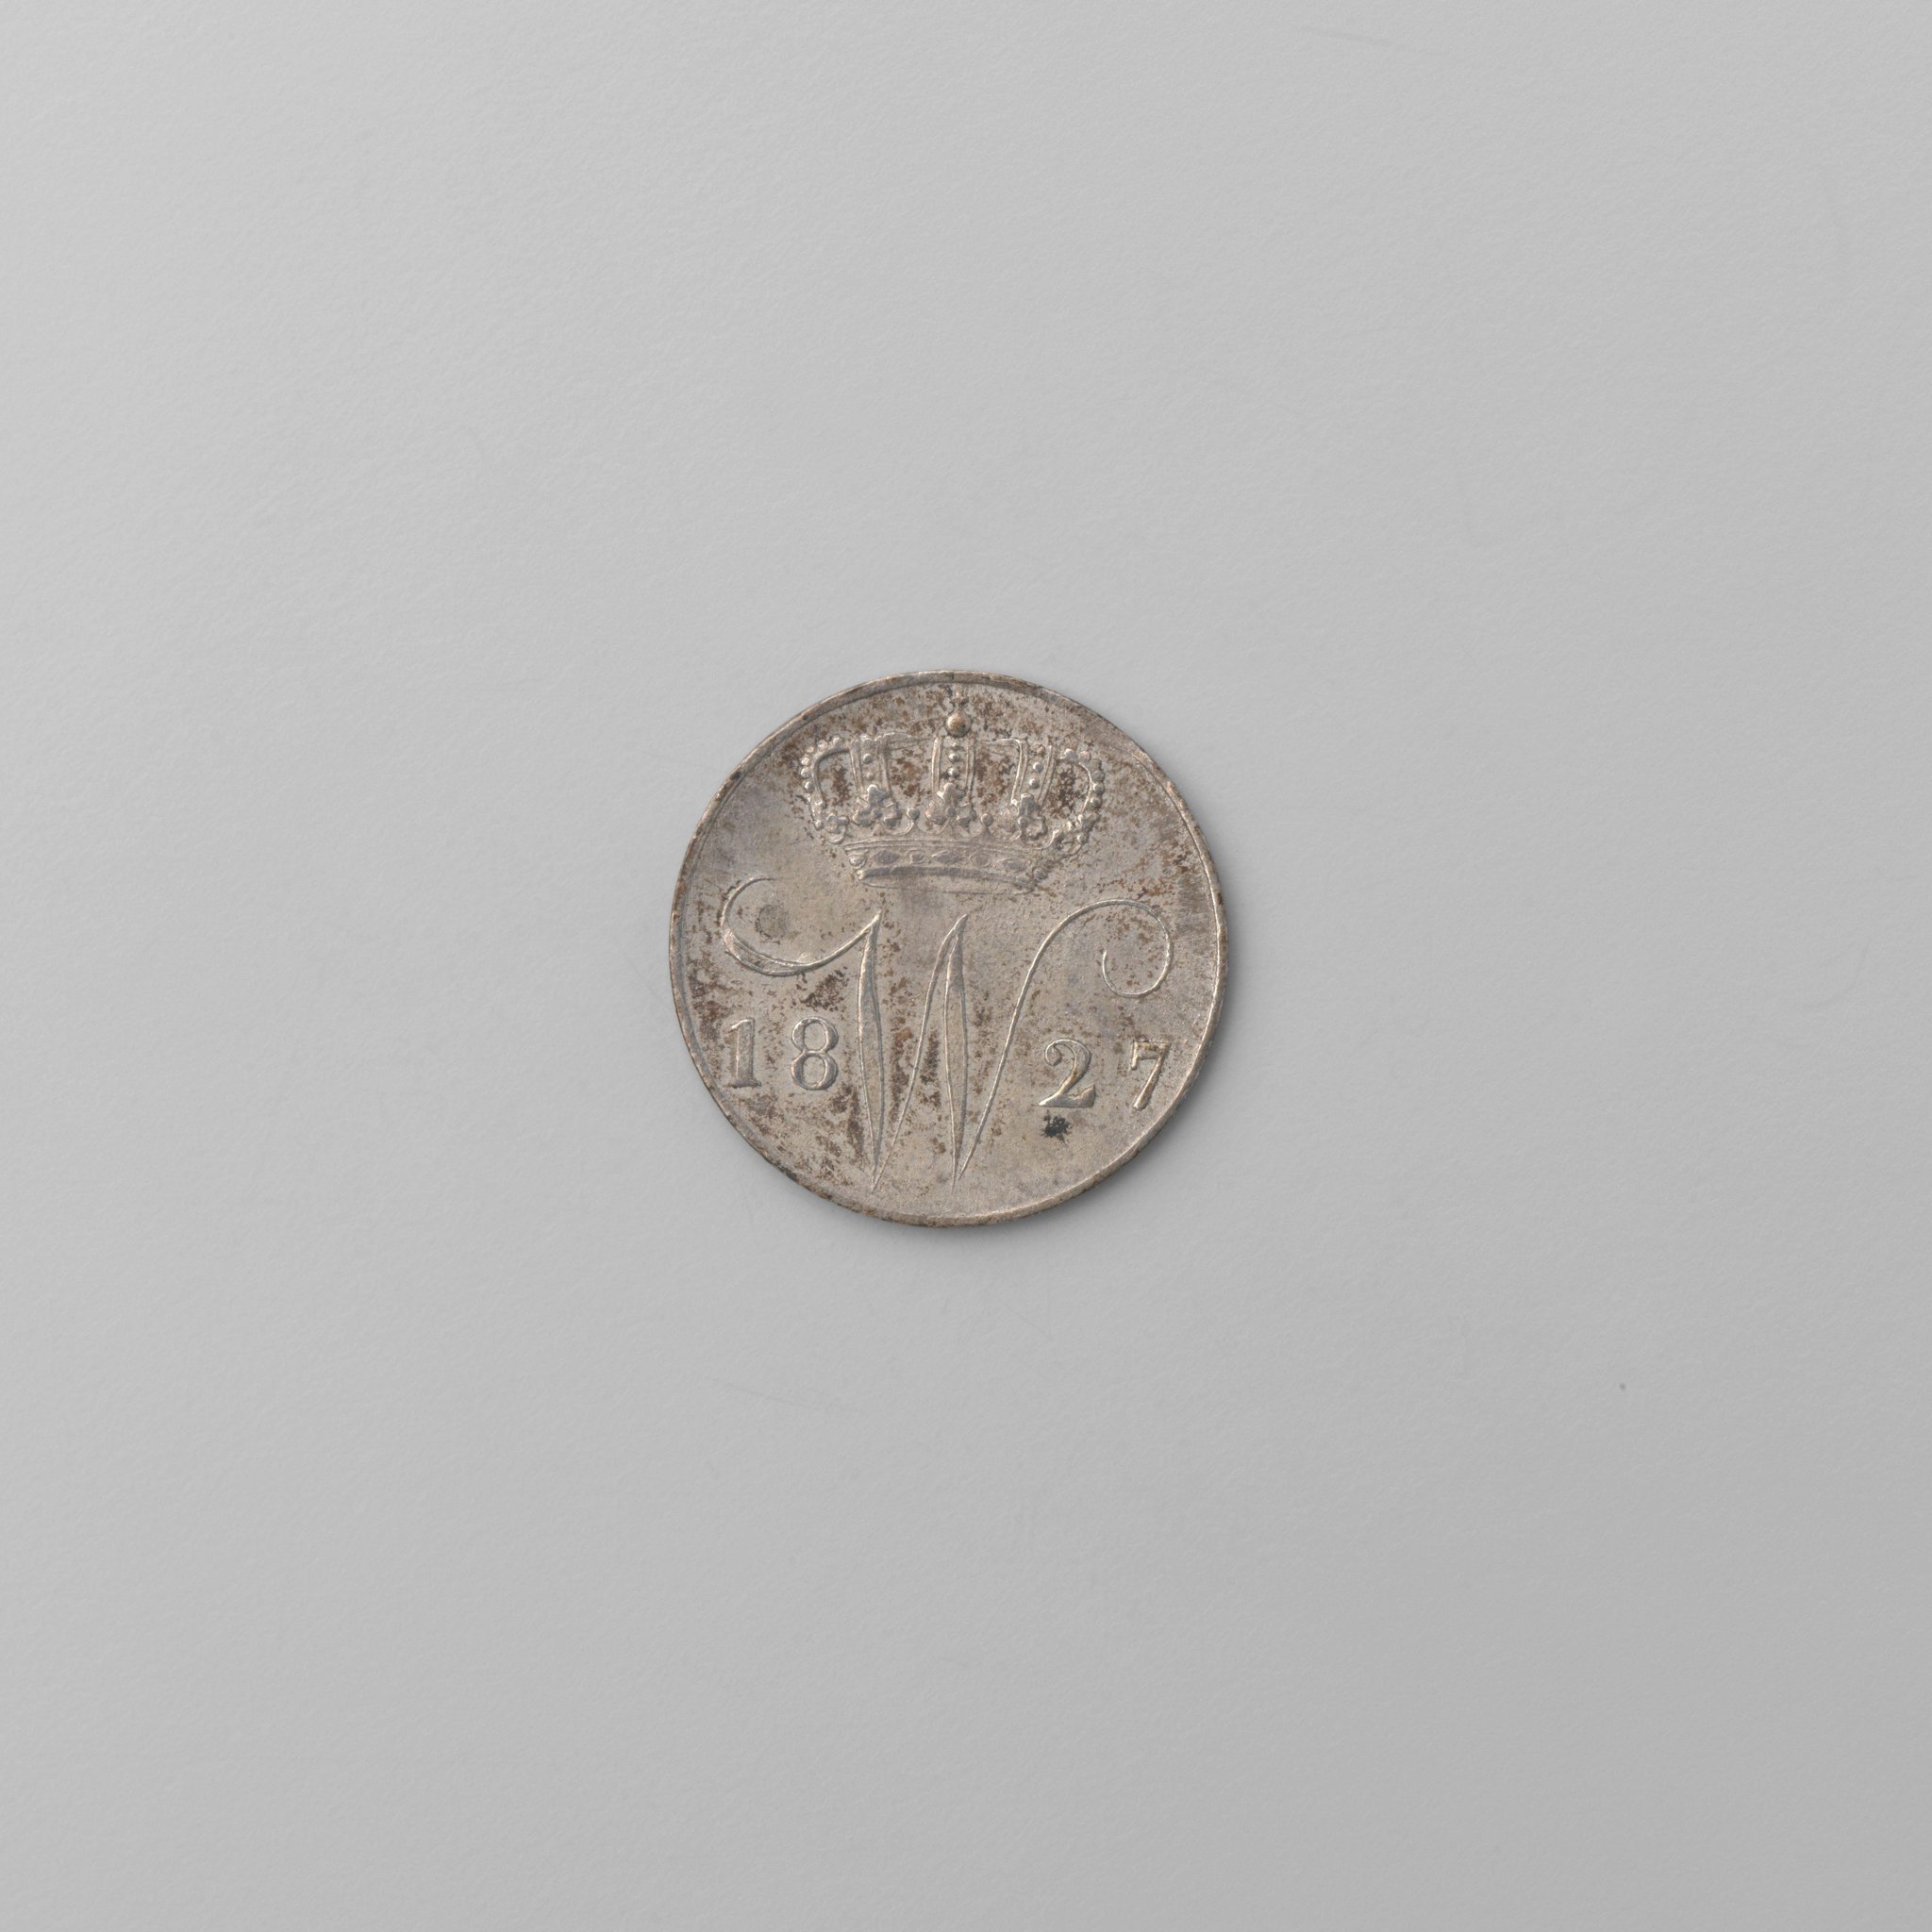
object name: vijf cent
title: Nederland, 5 cent, 1827 Utrecht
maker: william i of the netherlands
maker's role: koning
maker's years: 1772-1843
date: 1827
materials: silver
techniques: striking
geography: utrecht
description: Zilveren munt. Voorzijde: tussen jaartal gekroonde cursieve letter W. Keerzijde: tussen waarde-aanduiding 5 C. gekroond rijkswapenschild. Gladde rand.